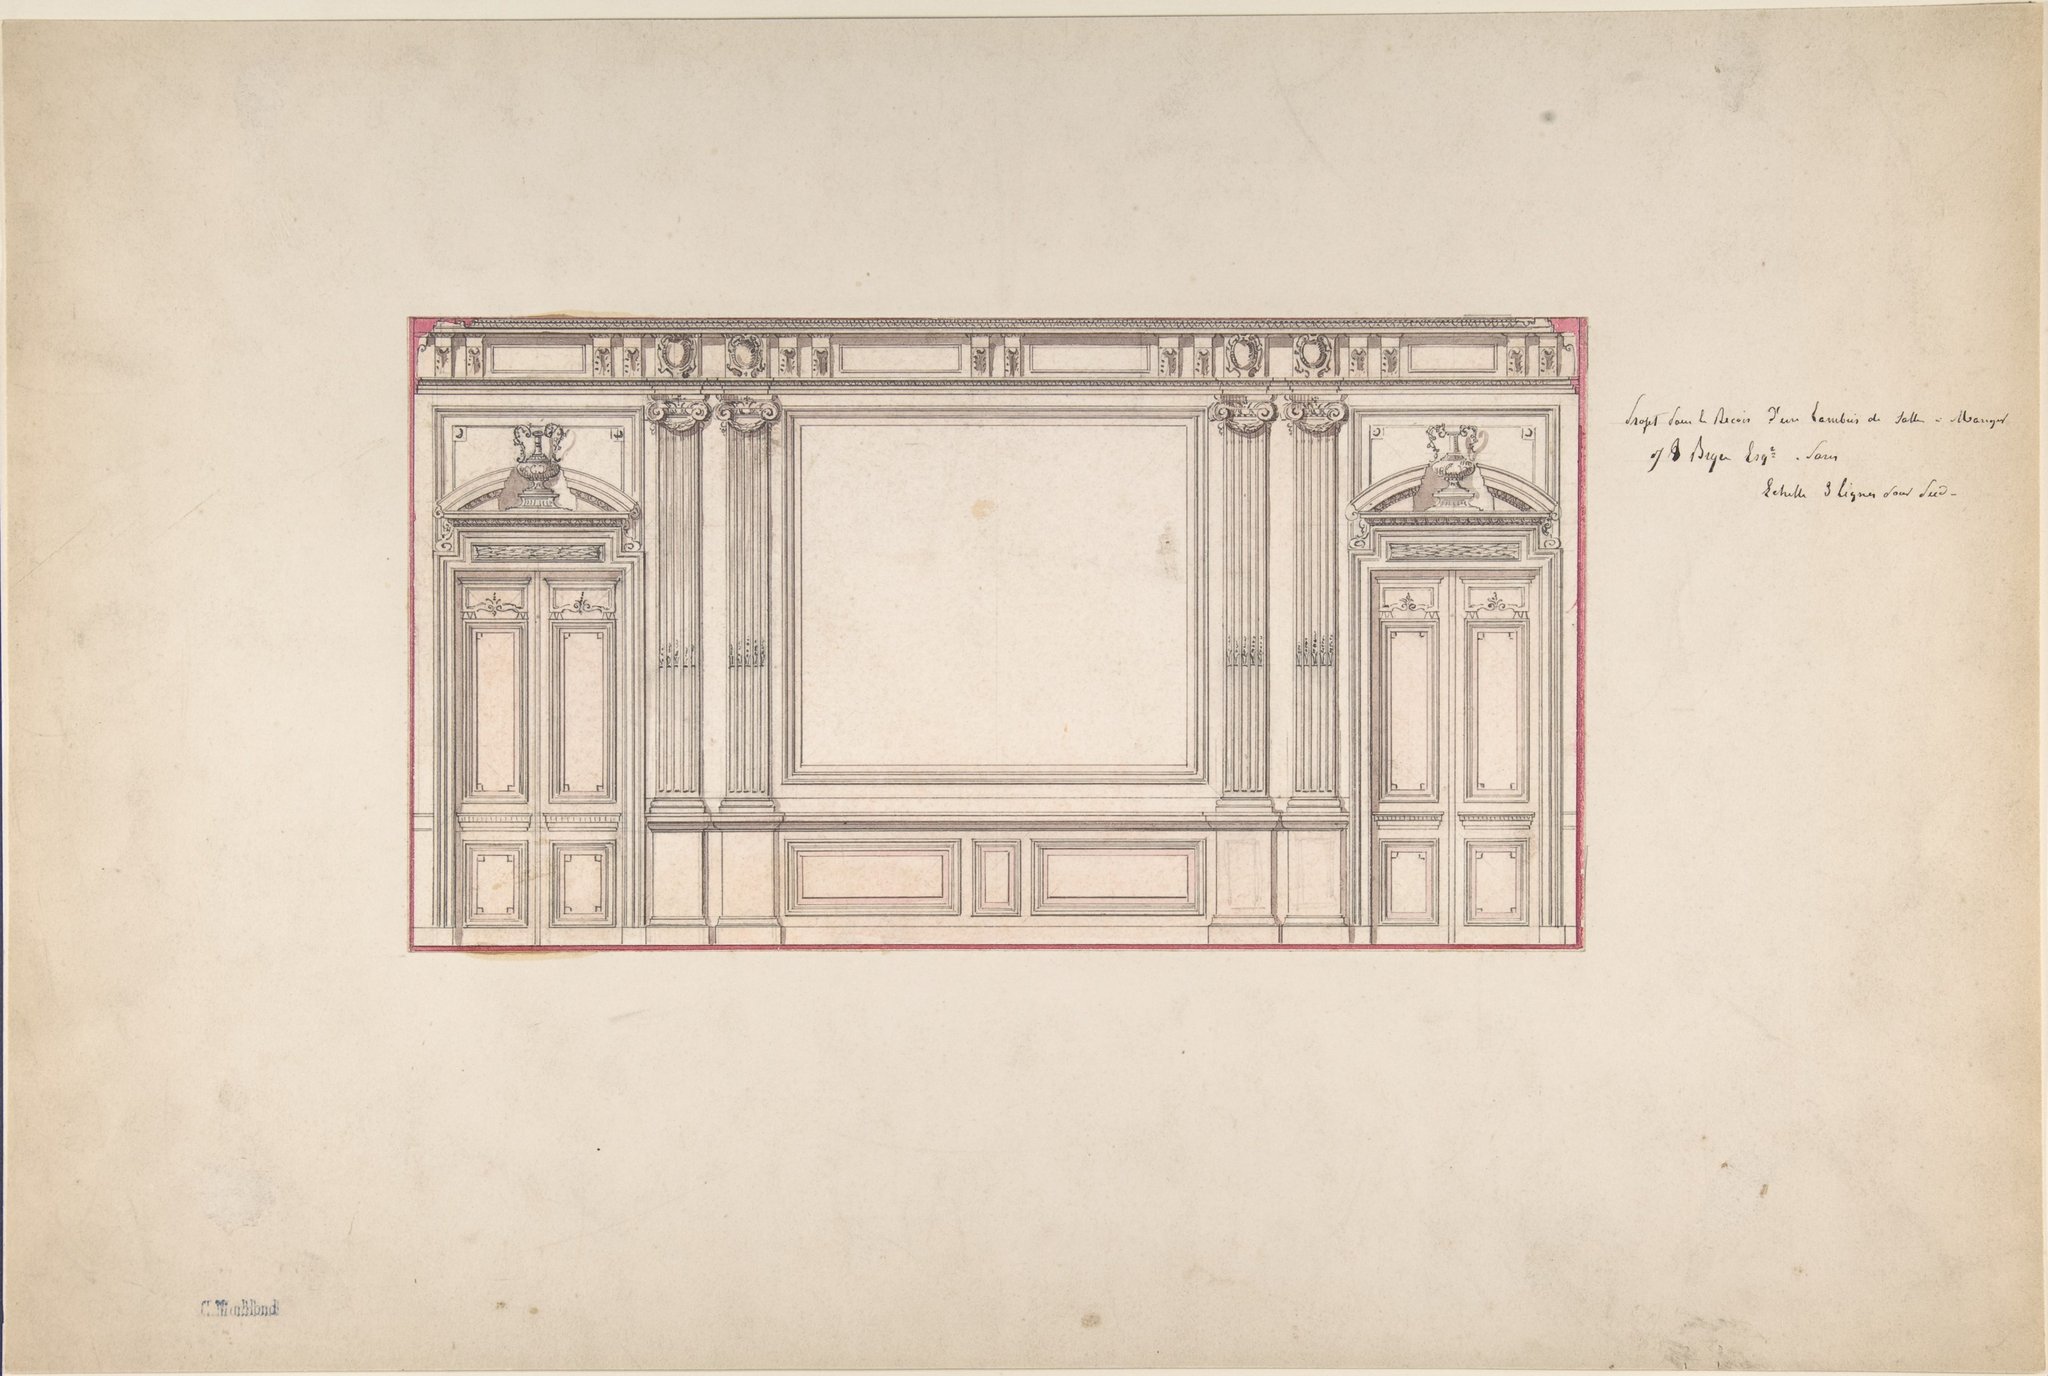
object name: drawing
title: Design for Wall Panelling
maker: charles monblond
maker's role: artist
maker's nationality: french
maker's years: 1800-1900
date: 1801-1900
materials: ink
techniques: brush, pen, wash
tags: architecture